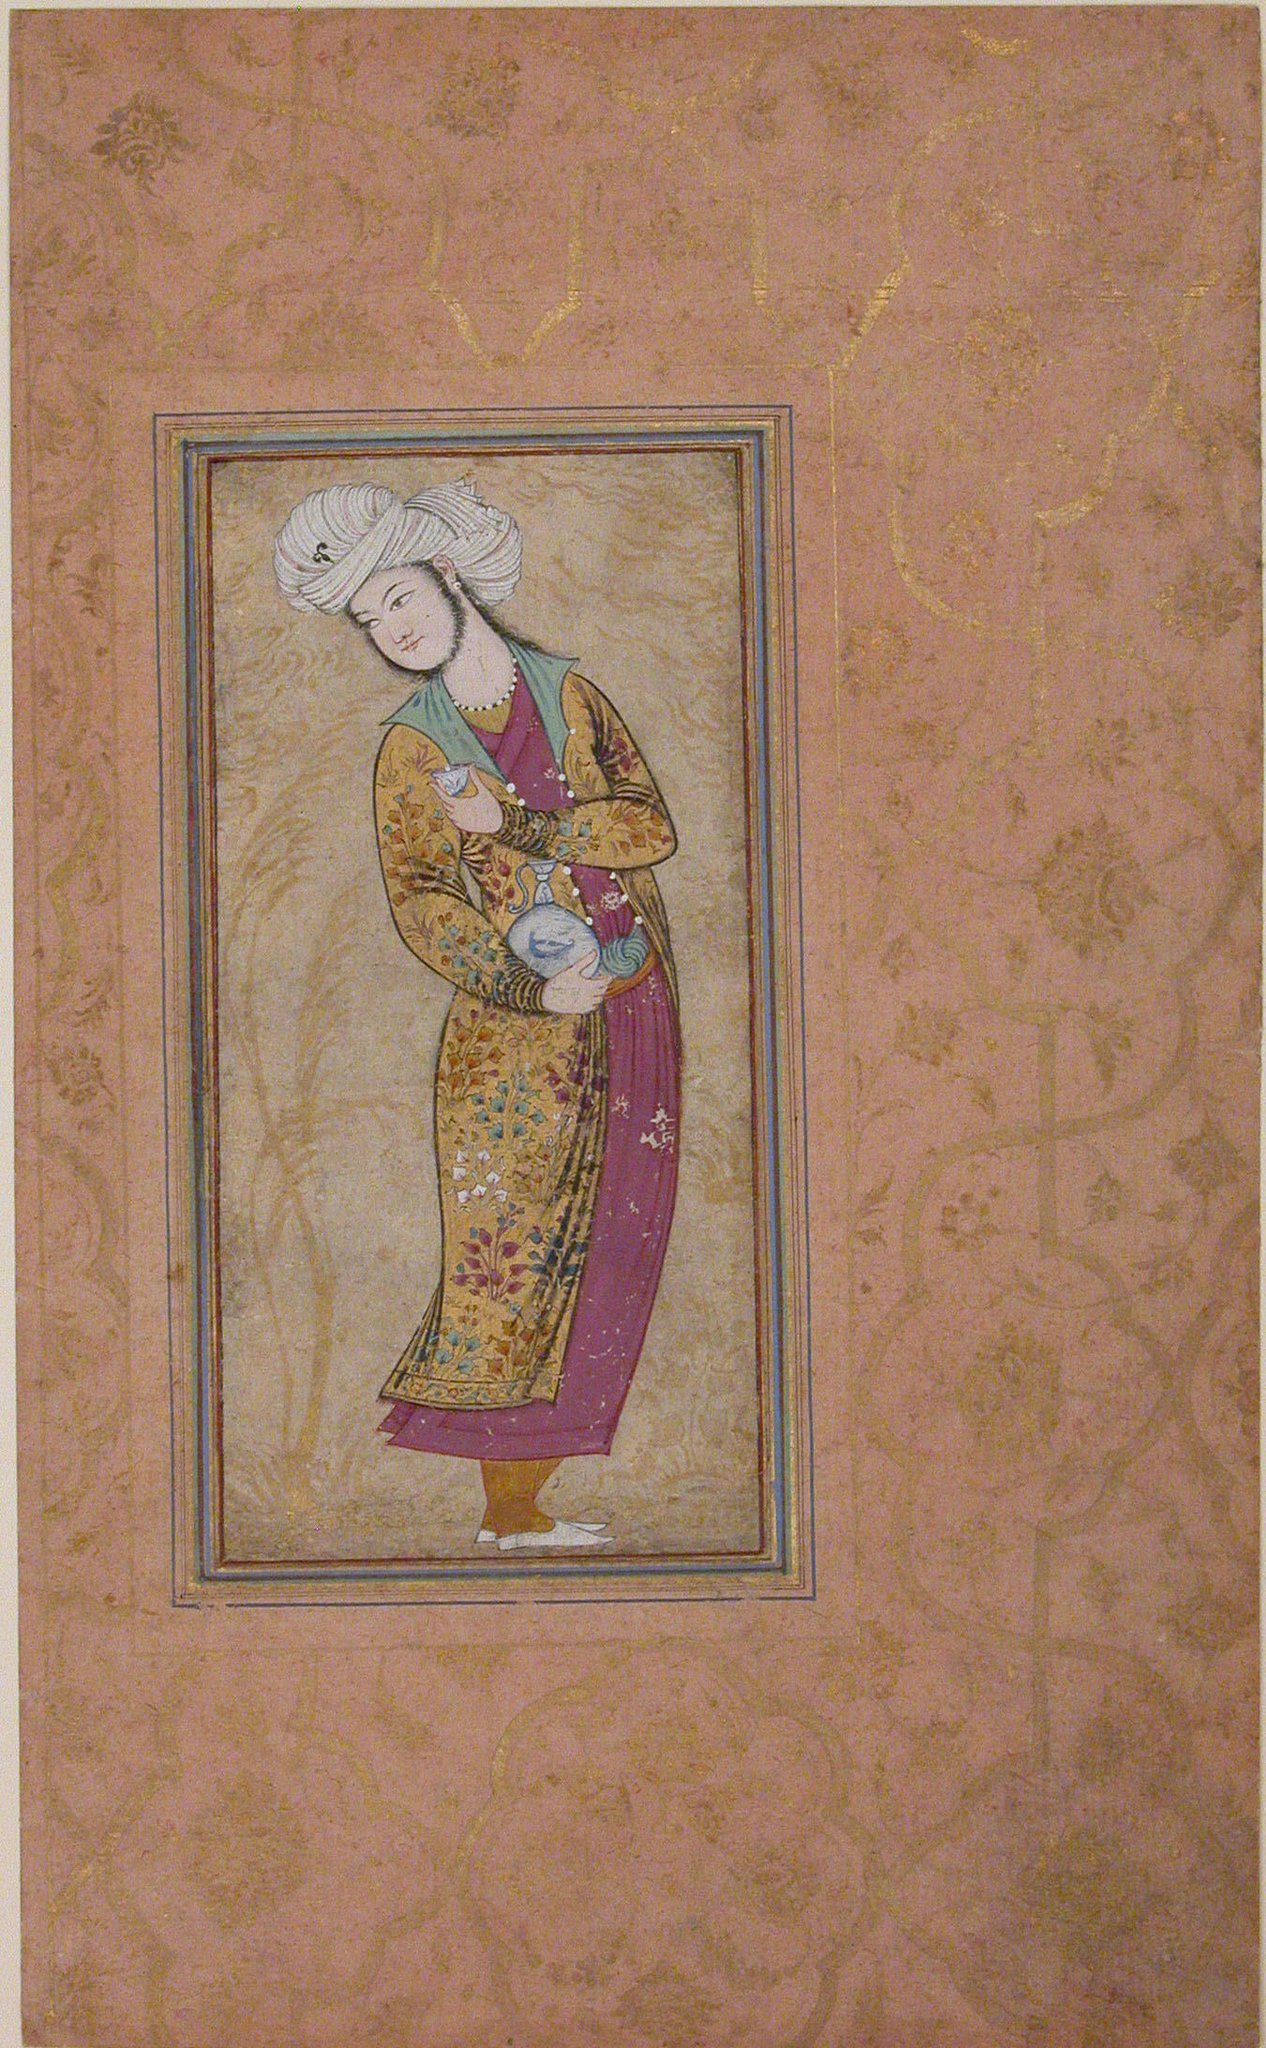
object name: illustrated album leaf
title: Portrait of a Youth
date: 1601-1633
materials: gold, ink, paper, watercolor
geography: iran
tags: men,portraits